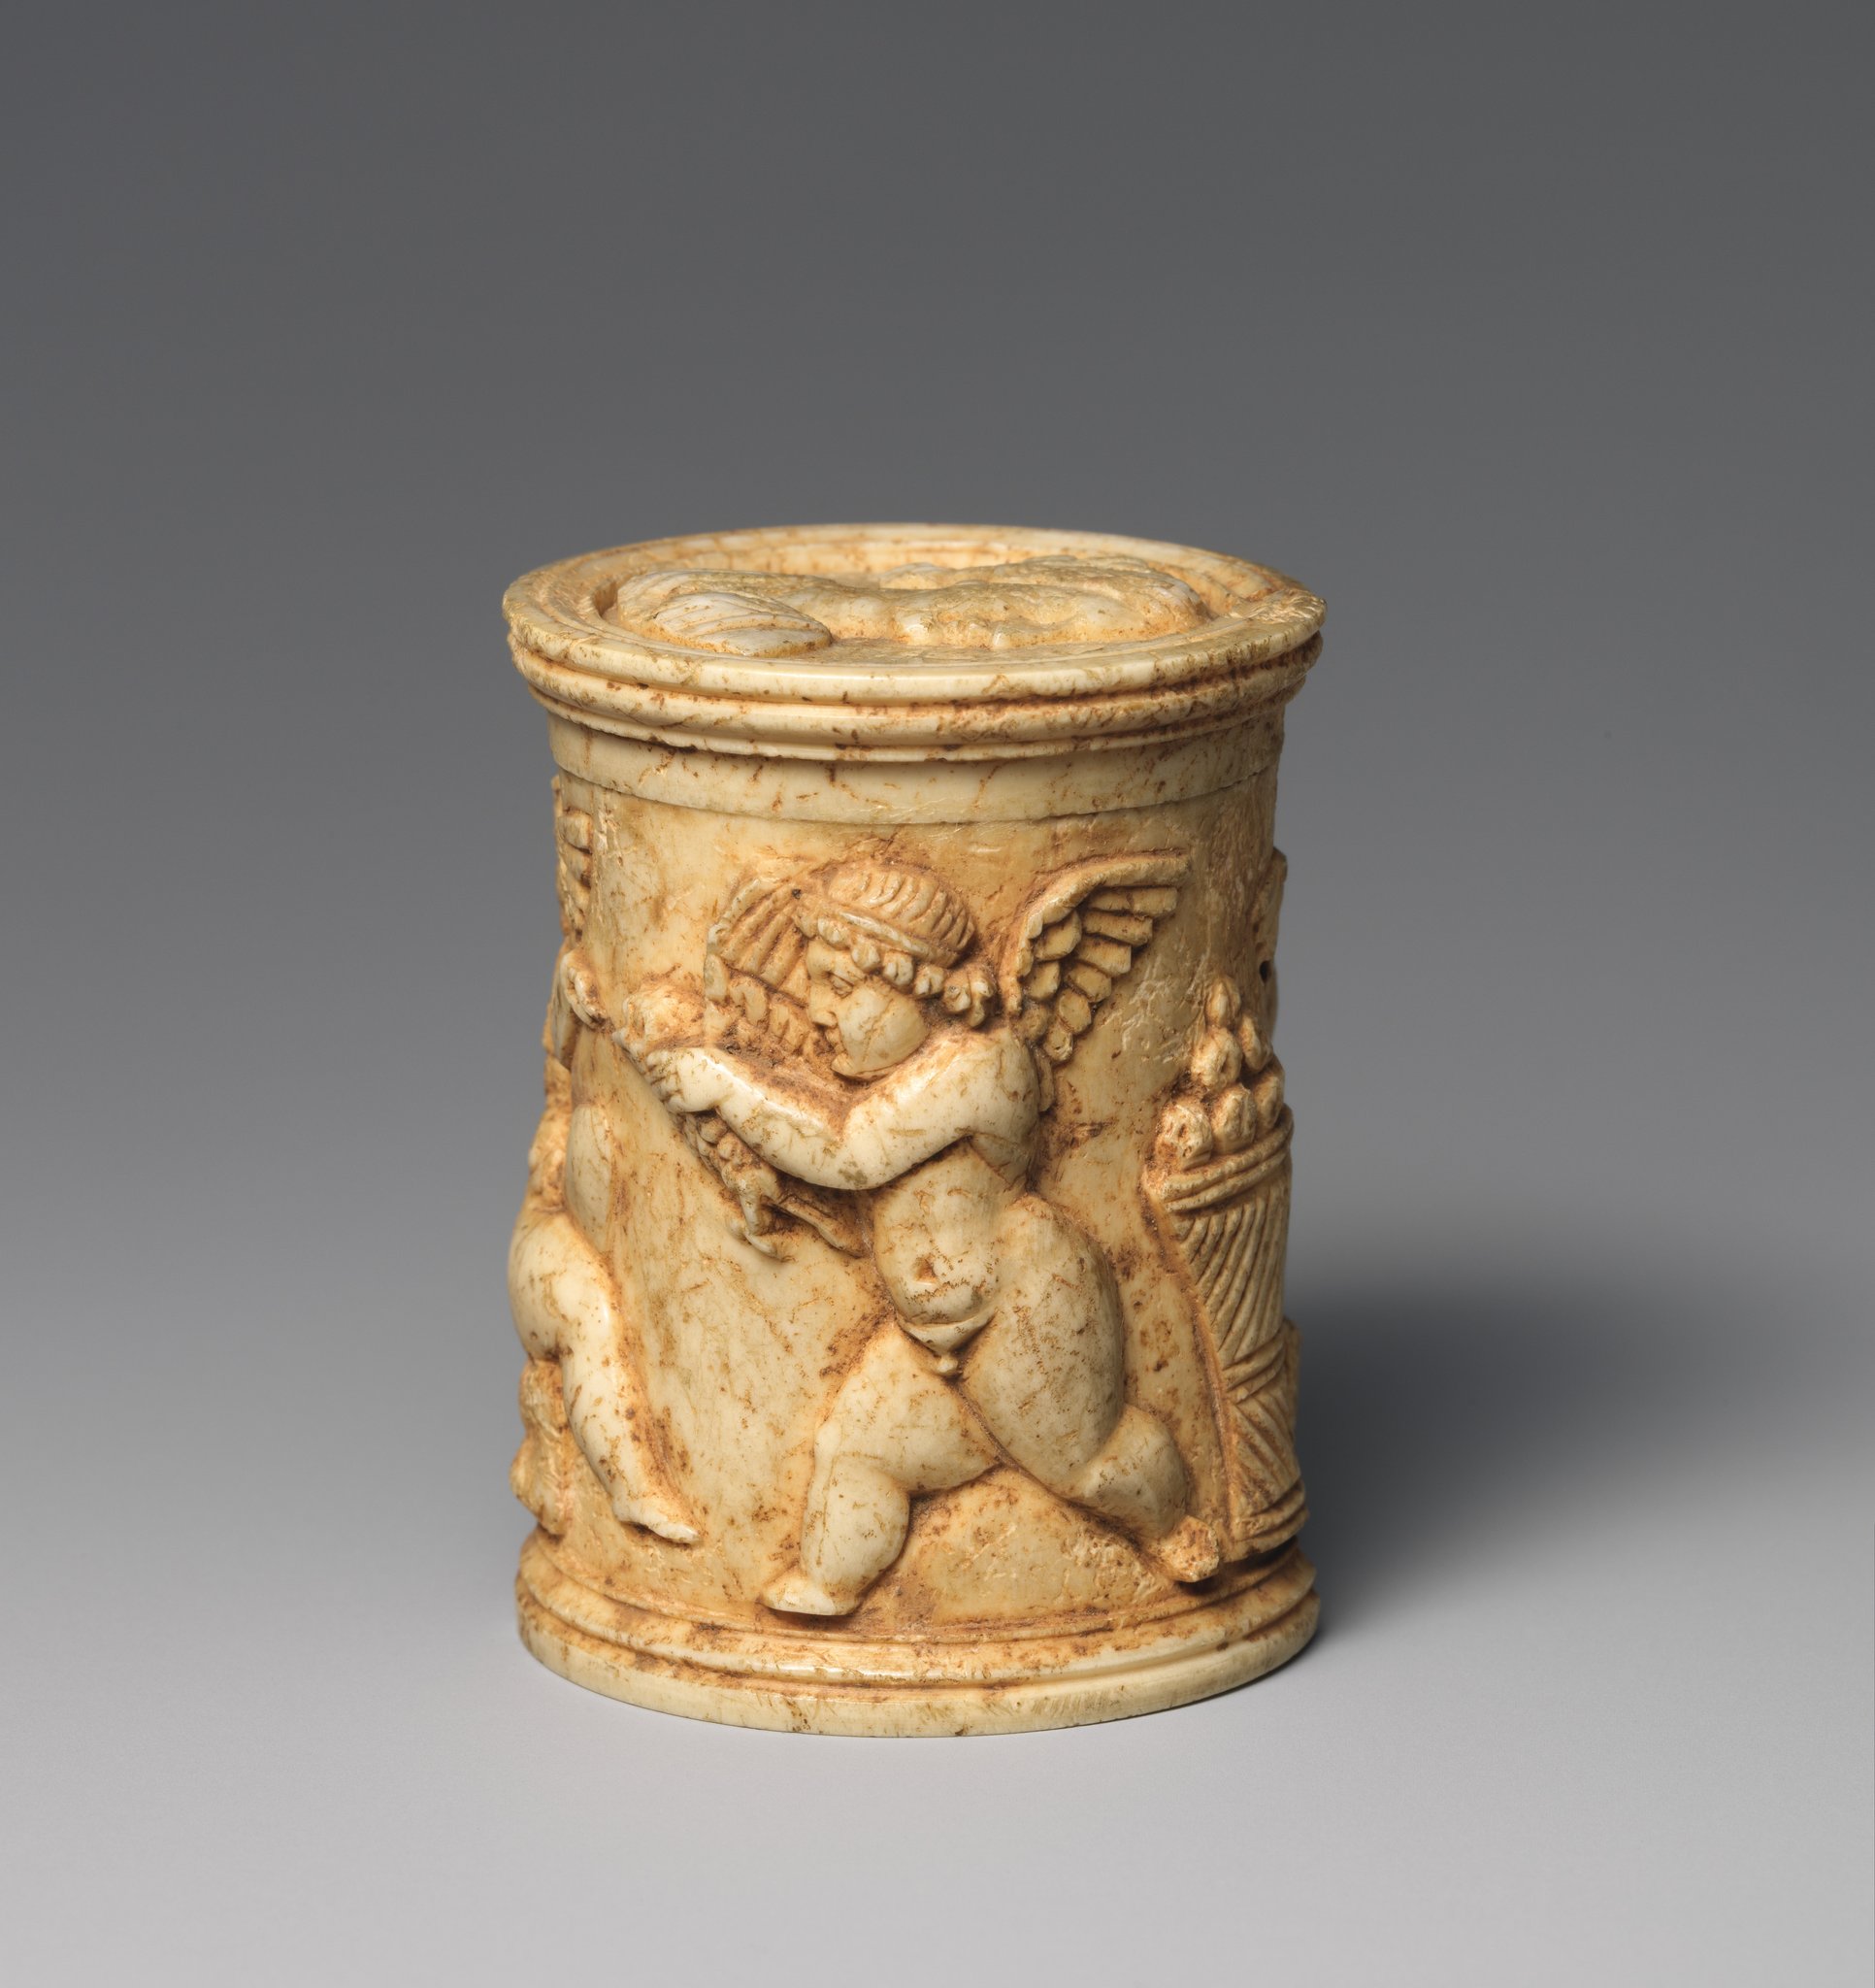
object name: pyxis with erotes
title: Ivory pyxis (box with lid)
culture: roman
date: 1-100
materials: ivory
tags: birds,grapes,women,cupid